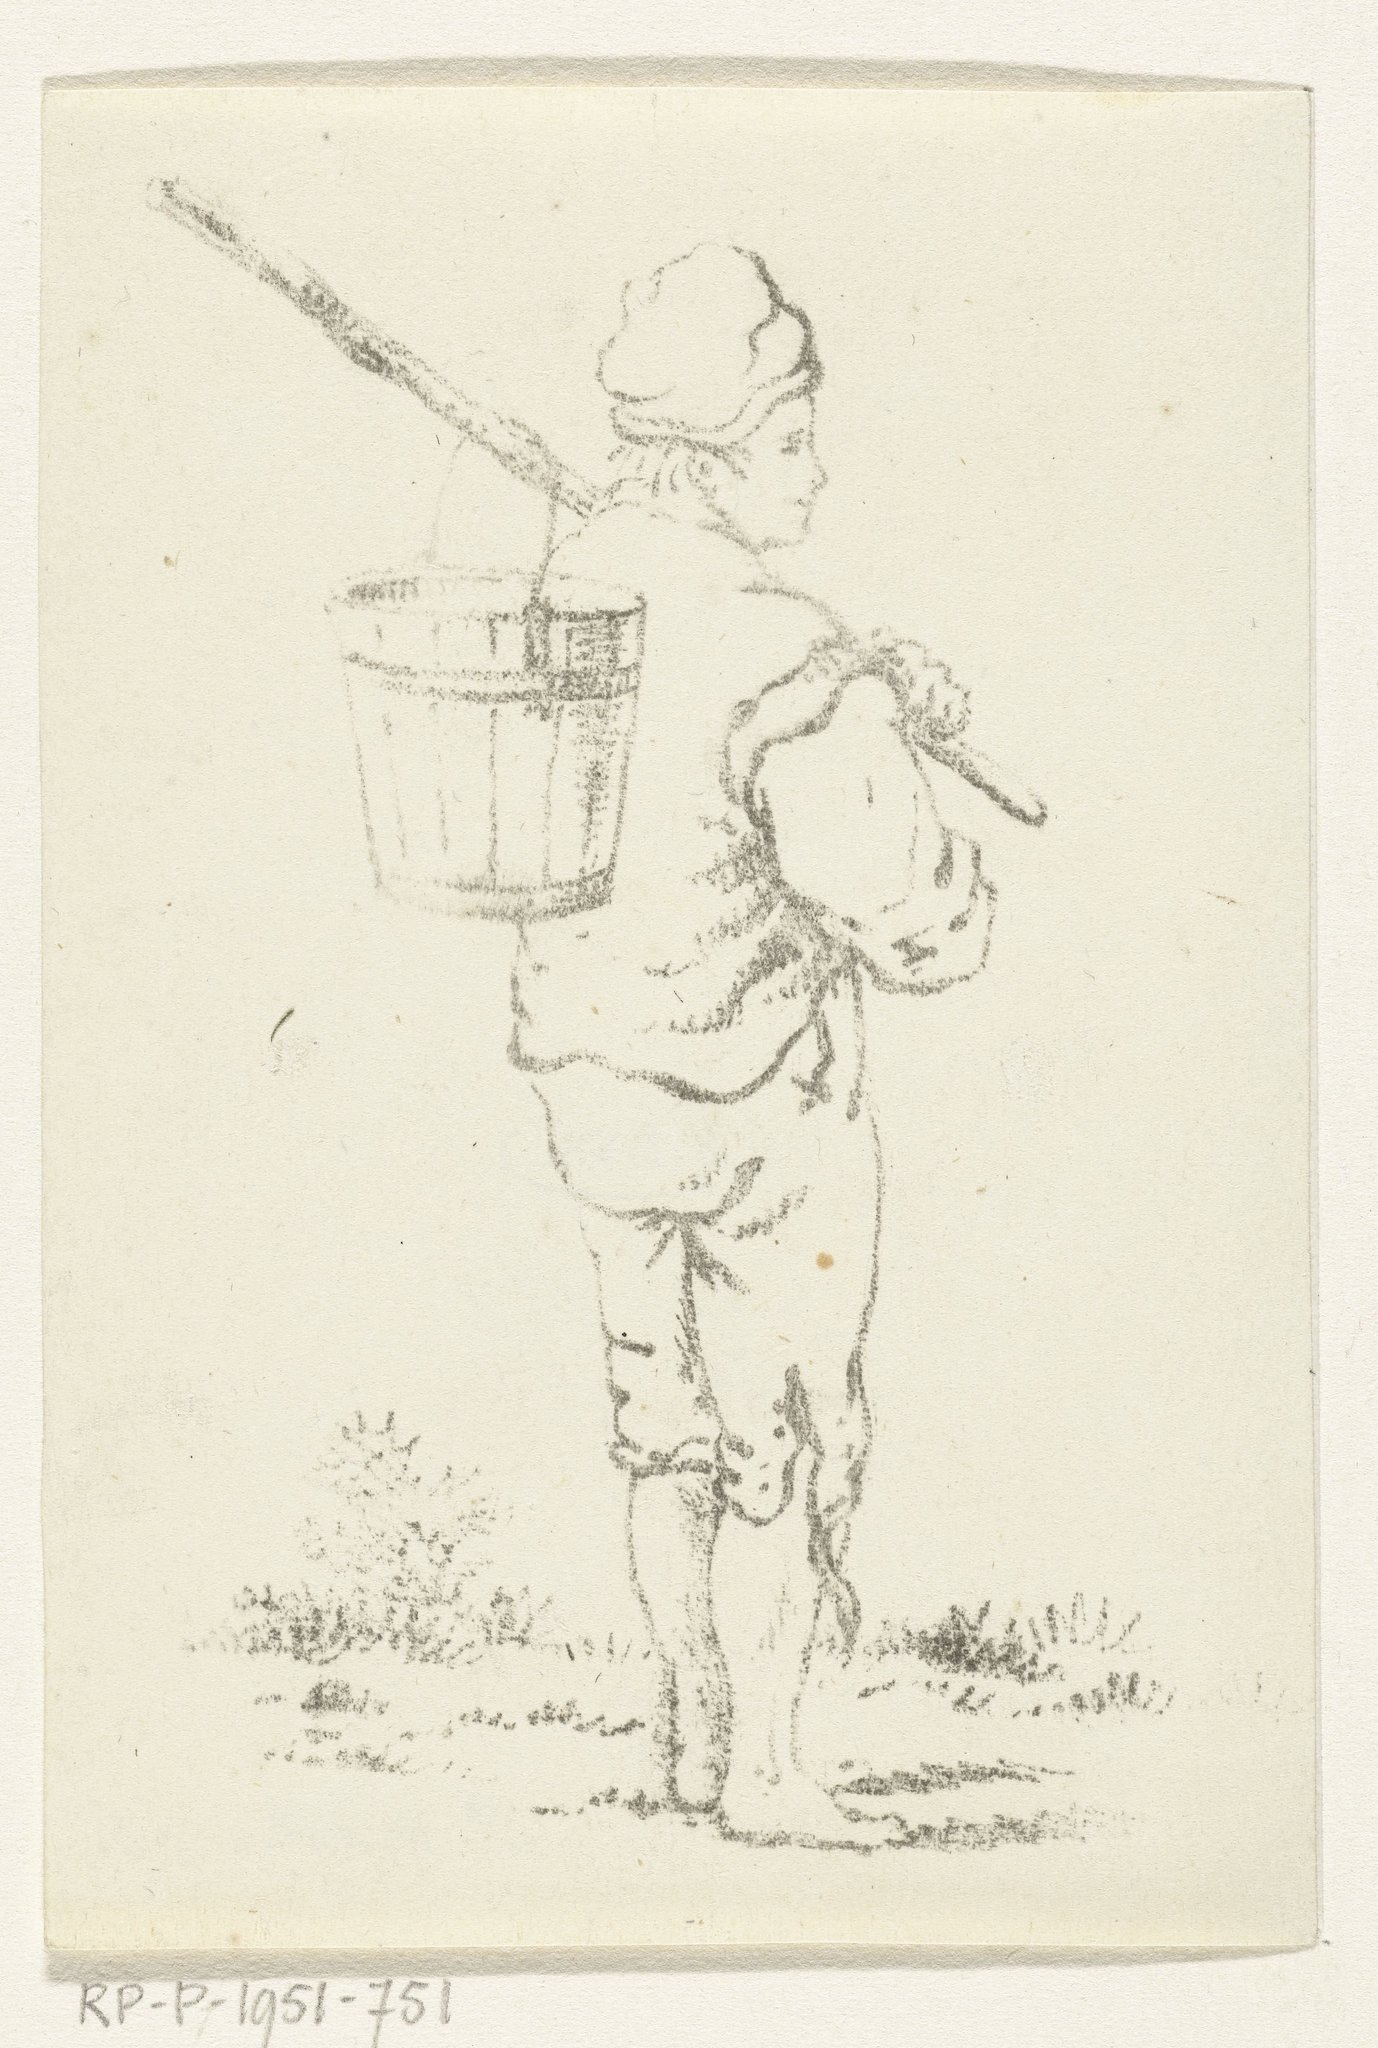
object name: print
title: Jongen met houten emmer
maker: pieter barbiers (iv)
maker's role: painter, print maker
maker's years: 1798-1848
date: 1808-1848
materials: paper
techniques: soft ground etching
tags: youth, adolescent, container of metal: bucket, can, canister, drum, tin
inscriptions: collector's mark: Lugt 2228